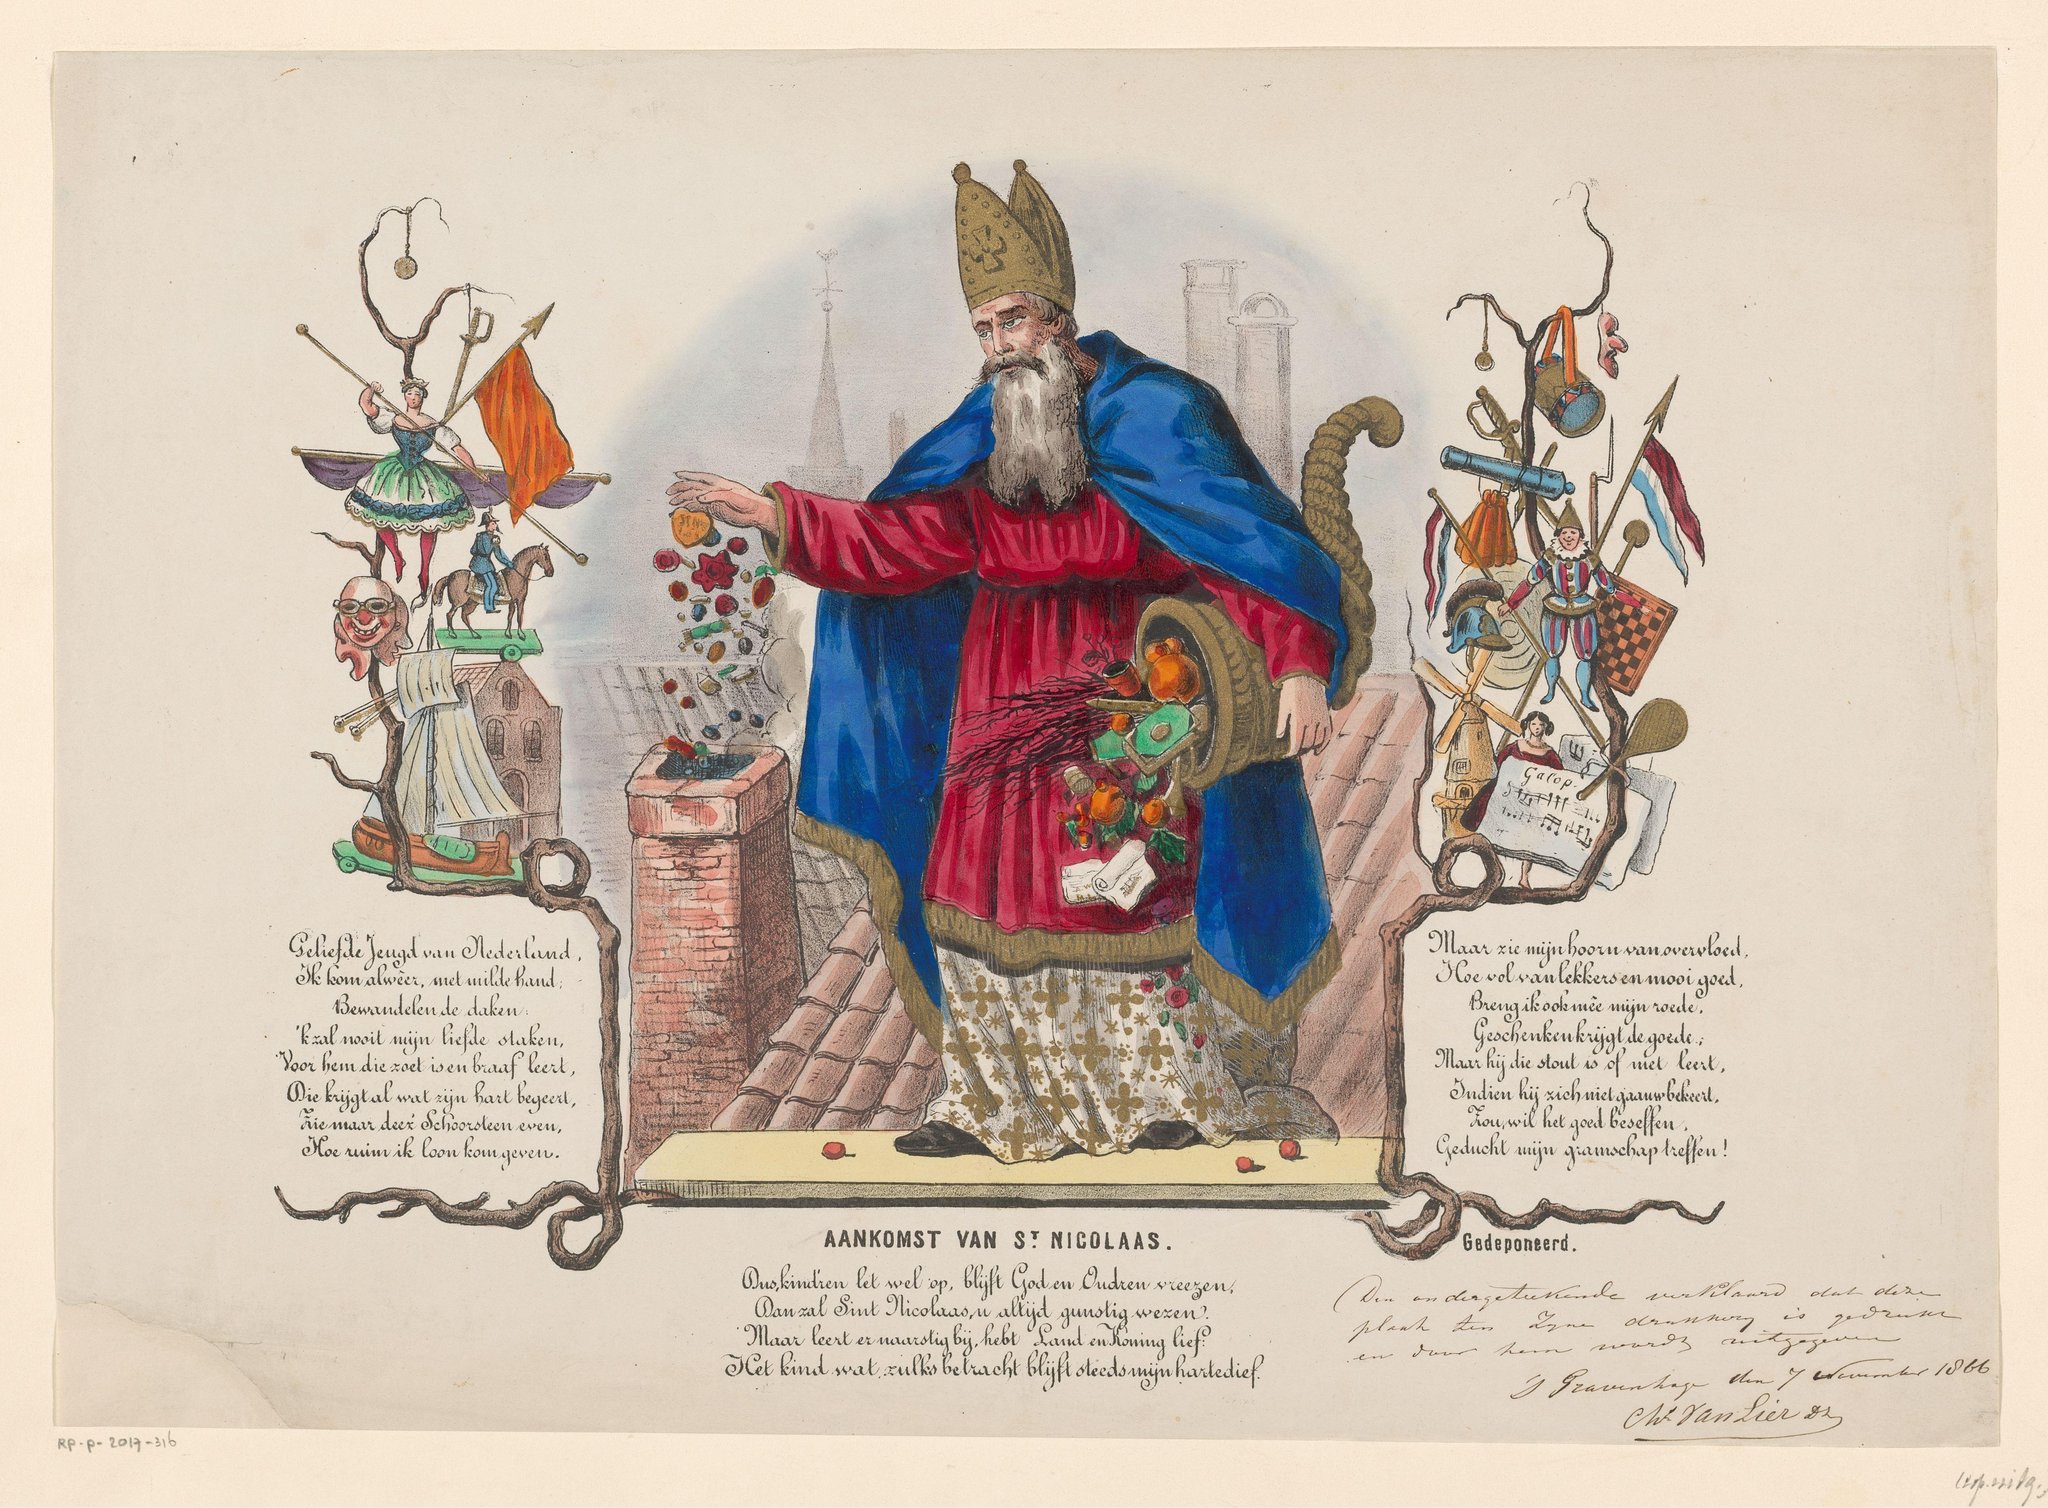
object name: print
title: Aankomst van St. Nicolaas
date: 1866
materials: paper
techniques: hand coloring, lithograph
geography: the hague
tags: chimney, 'cornucopia', horn of plenty, festivities on st. nicholas (eve) (december 5), (playing with) toys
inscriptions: : ‘Gedeponeerd.’, : ‘Den ondergetekende verklaard dat deze / plaat ten zijnen drukkerij is gedrukt / en door hem wordt uitgegeven. / 's Gravenhage den 7 november 1866’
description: Sinterklaas staat op een dak en gooit snoep in een schoorsteen. Onder zijn linkerarm heeft hij een hoorn des overvloeds waar ook een roe uitsteekt. Links en rechts twee takken met daarin speelgoed. Bij de afbeelding een gedicht bestaande uit drie strofen.